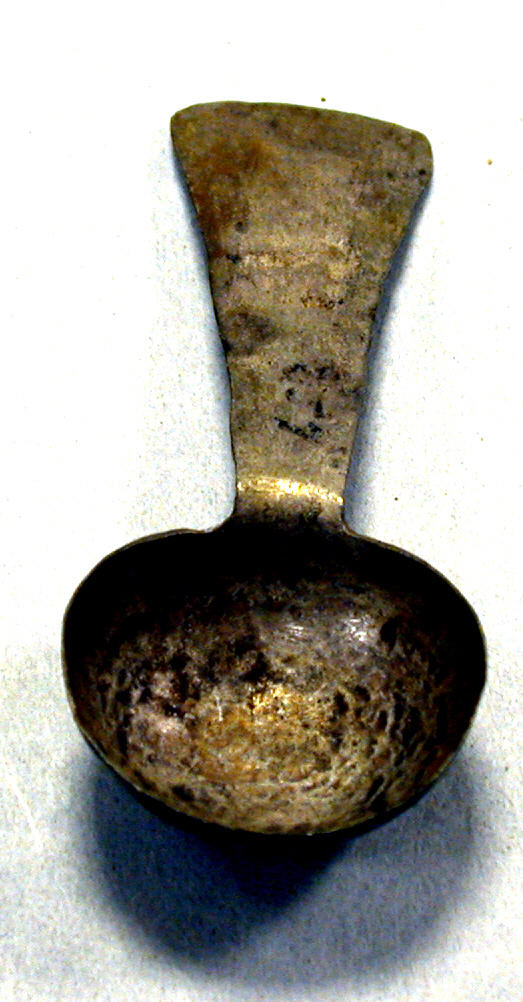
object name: spoon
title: Hammered Silver Spoon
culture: peruvian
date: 701-1566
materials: gilt, silver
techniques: hammering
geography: peru